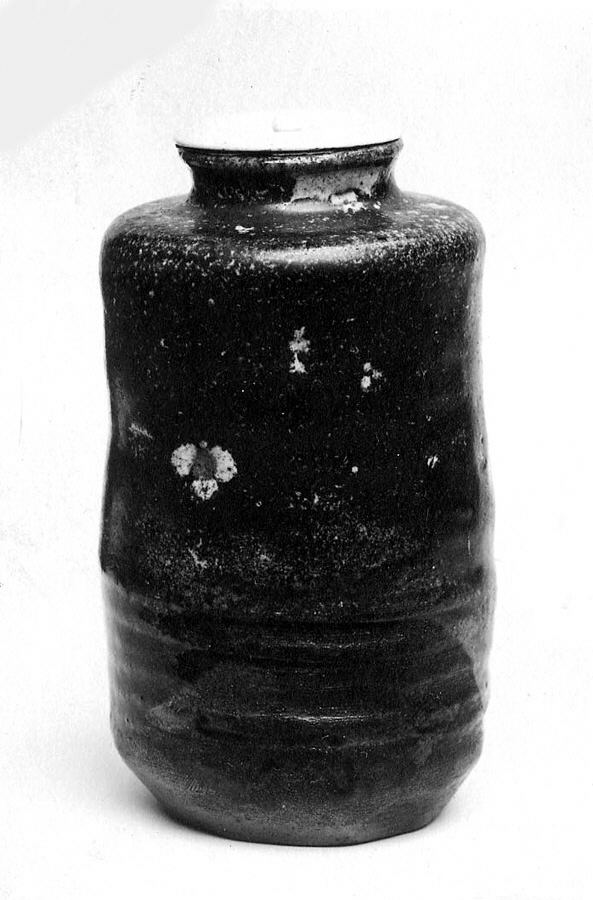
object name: tea caddy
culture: japanese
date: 1701-1800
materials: clay, glaze, ivory